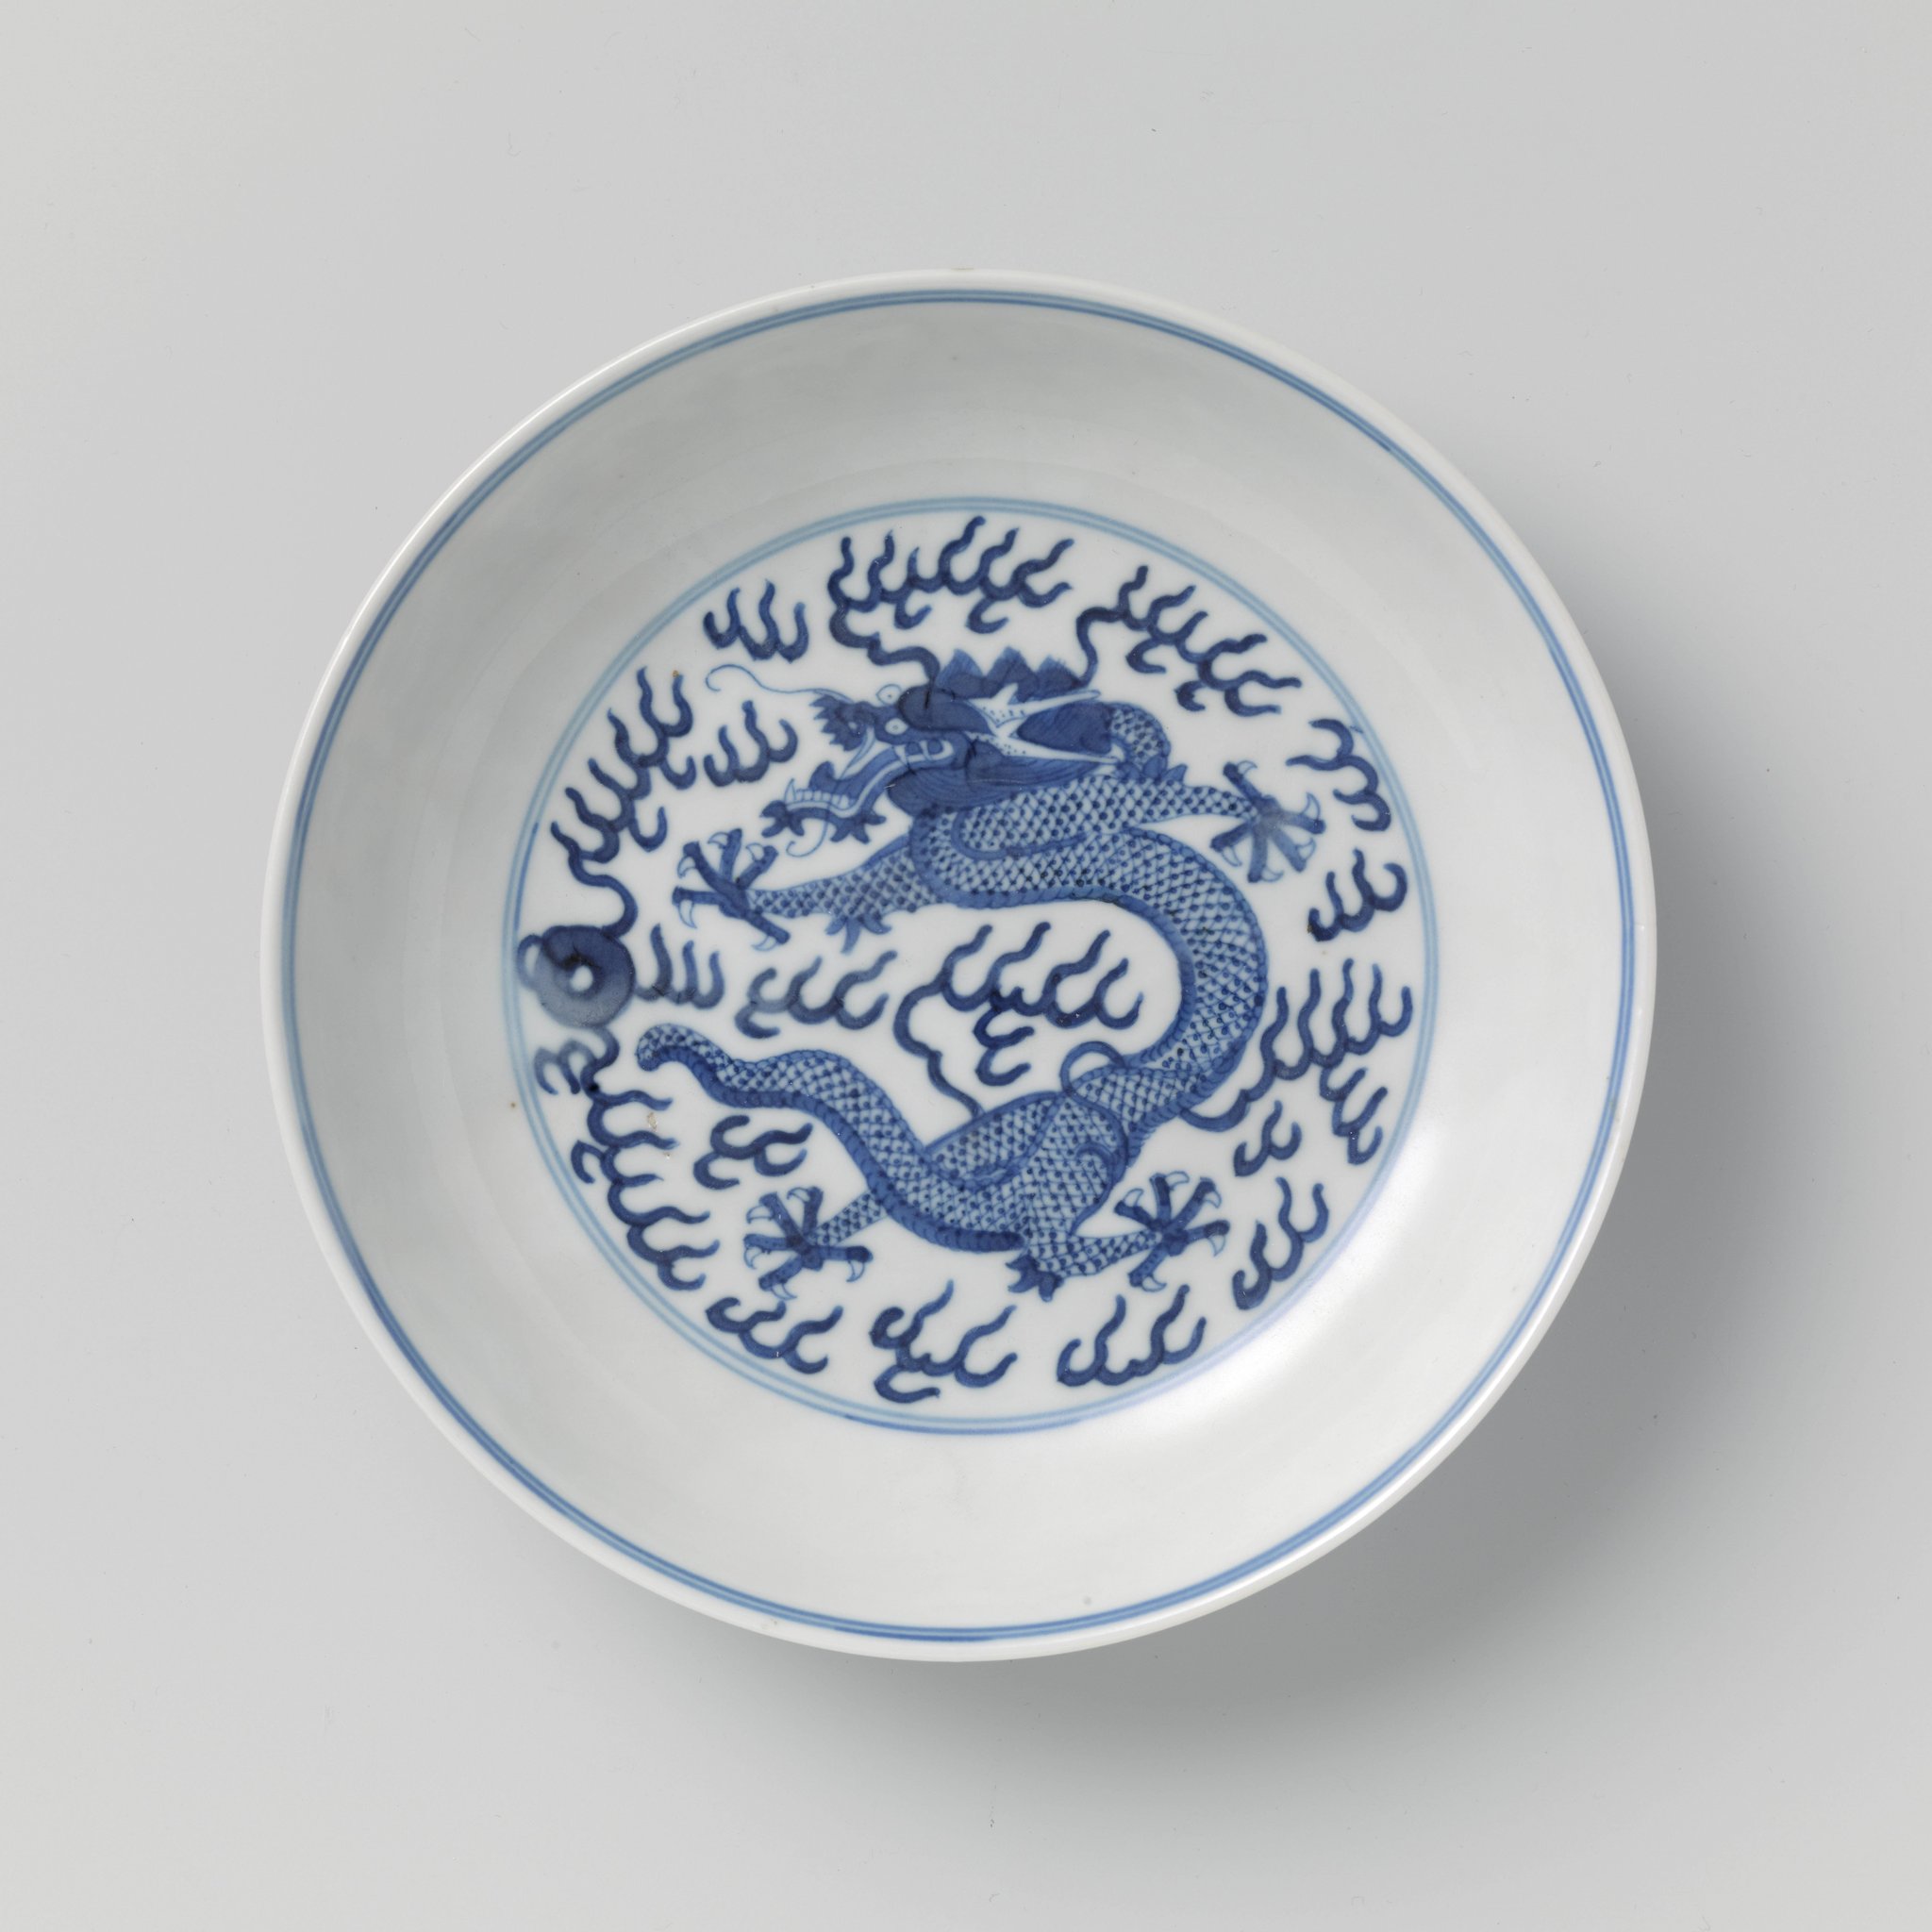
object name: platter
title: Saucer-dish with pearl chasing dragons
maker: Anonymous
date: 1875-1908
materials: cobalt, glaze, paint, porcelain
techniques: firing, turning, vitrification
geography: china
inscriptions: mark: ‘大 清 光 緒 年 製’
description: Schotel van porselein met ronde wand, beschilderd in onderglazuur blauw. Op het plat een parel najagende, vijfklauwige draak; op de buitenwand twee vijfklauwige draken met parels. Gemerkt op de onderzijde met het zes-karaktermerk van keizer Guangxu. Blauw-wit.